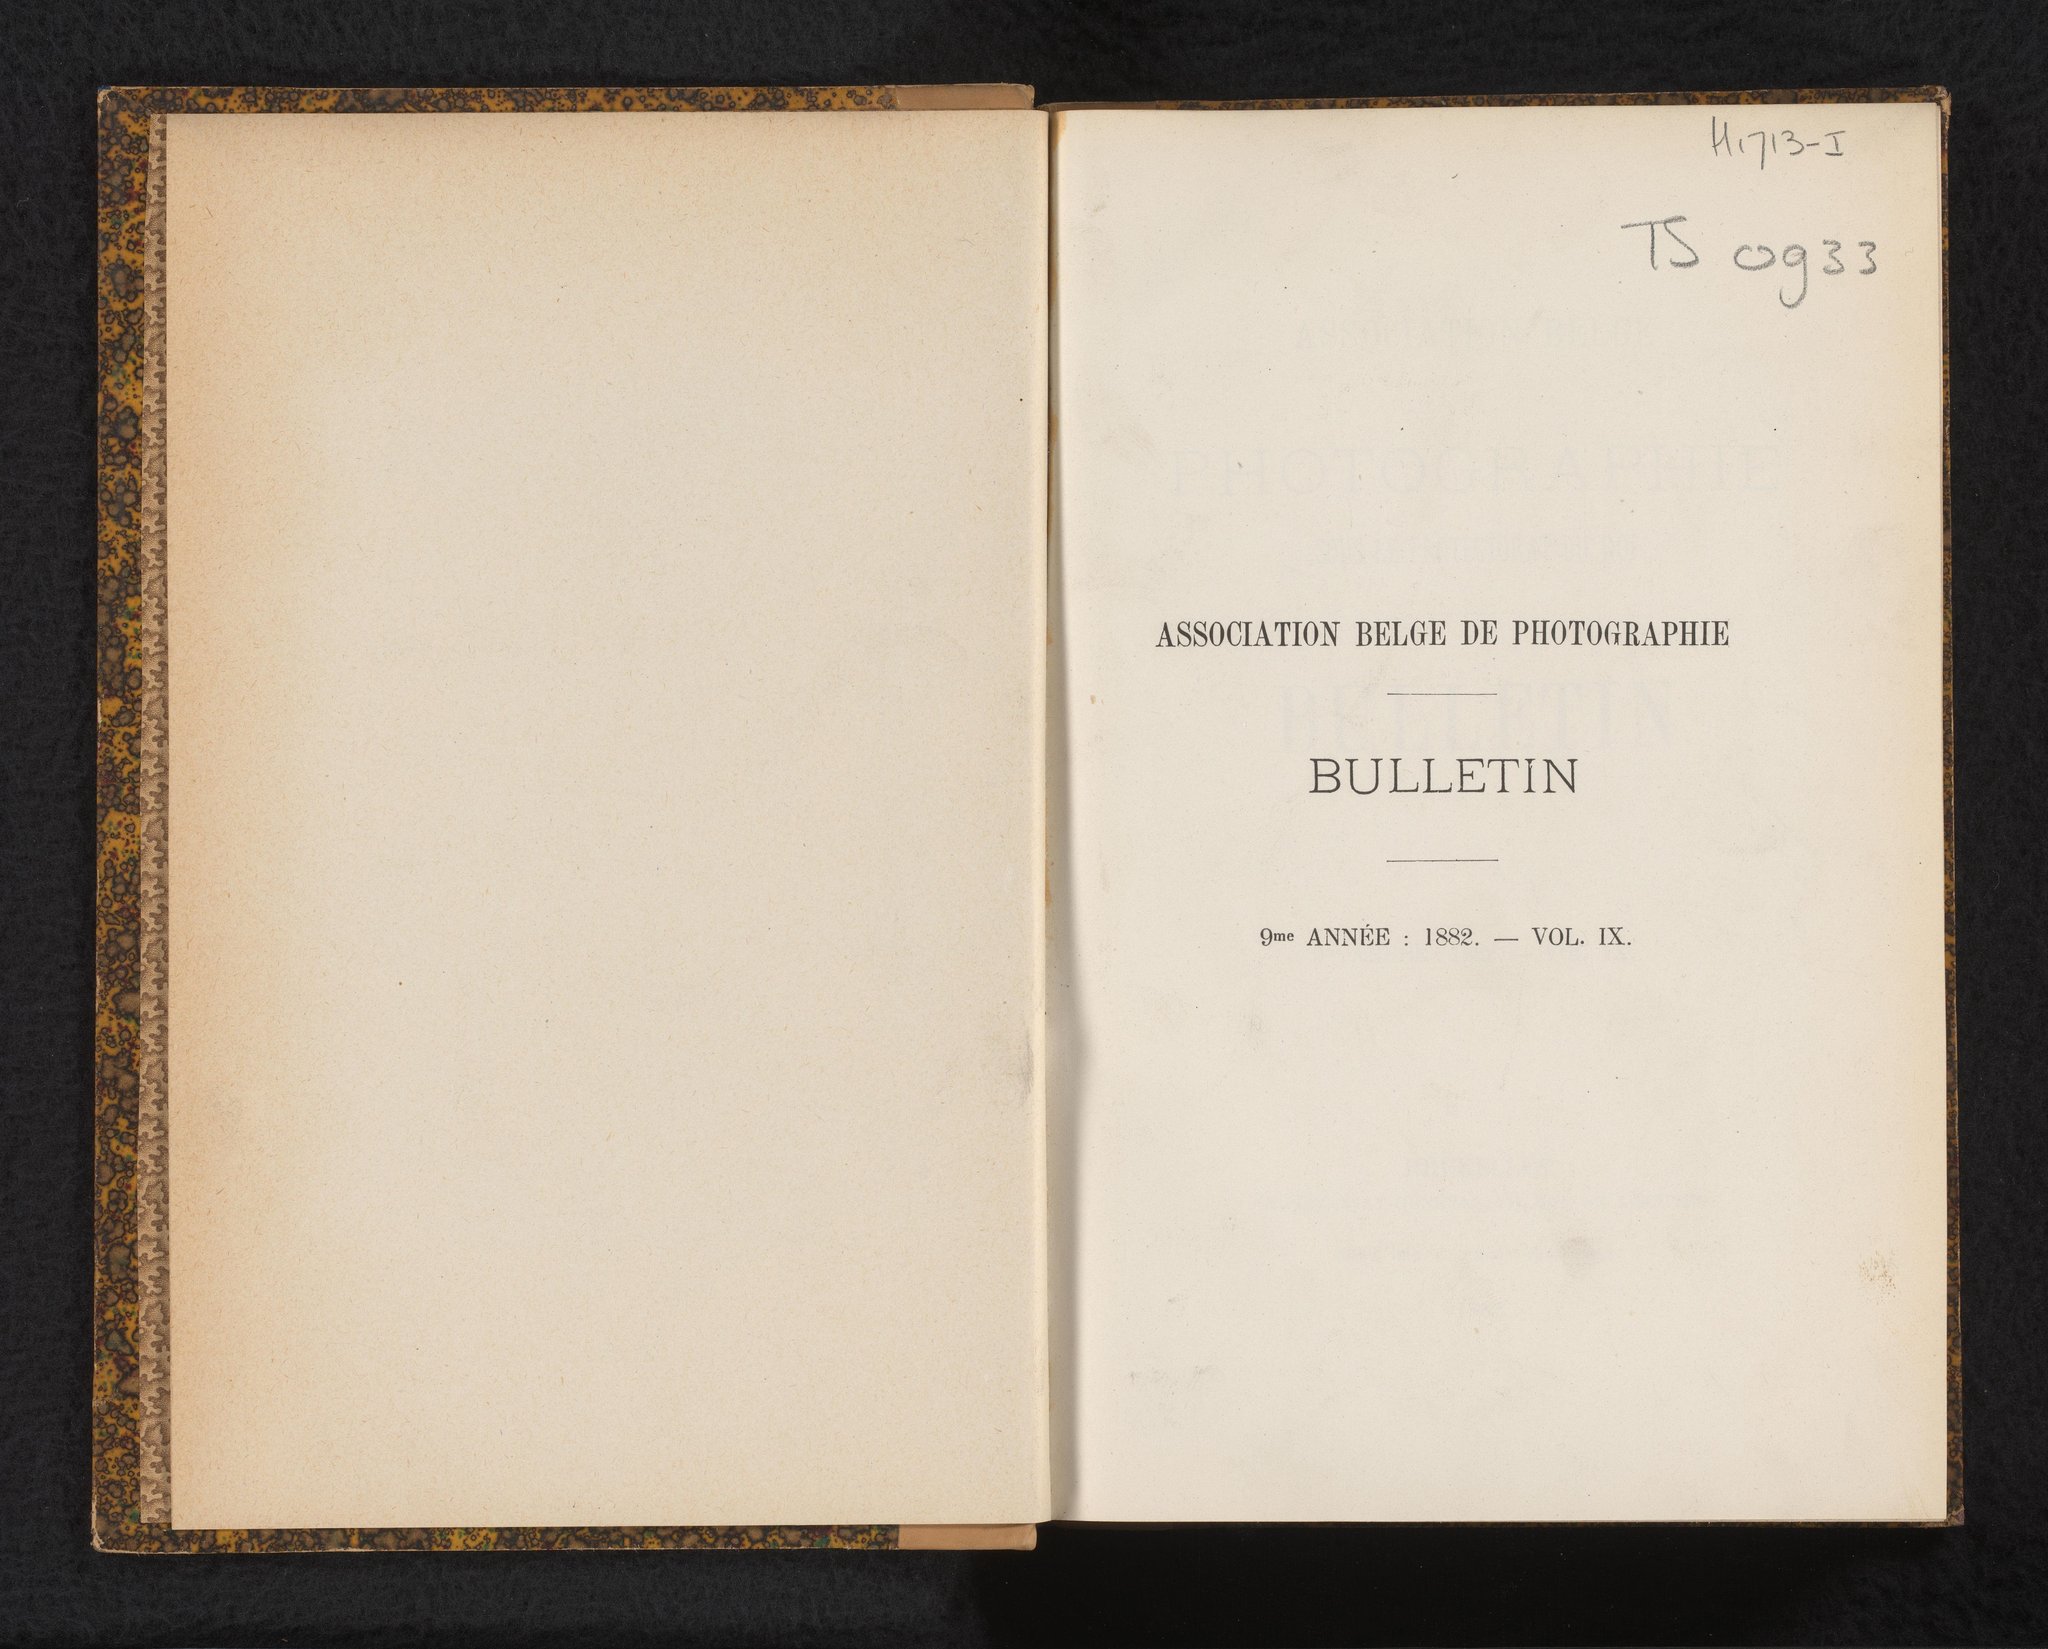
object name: book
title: Association belge de photographie bulletin 9me année: 1882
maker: c. annoot-braeckman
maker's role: printer, publisher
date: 1882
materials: paper, cardboard, leather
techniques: marbled paper, photograph, heliotype, letterpress printing, marbling, photoaquatint, woodburytype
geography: ghent